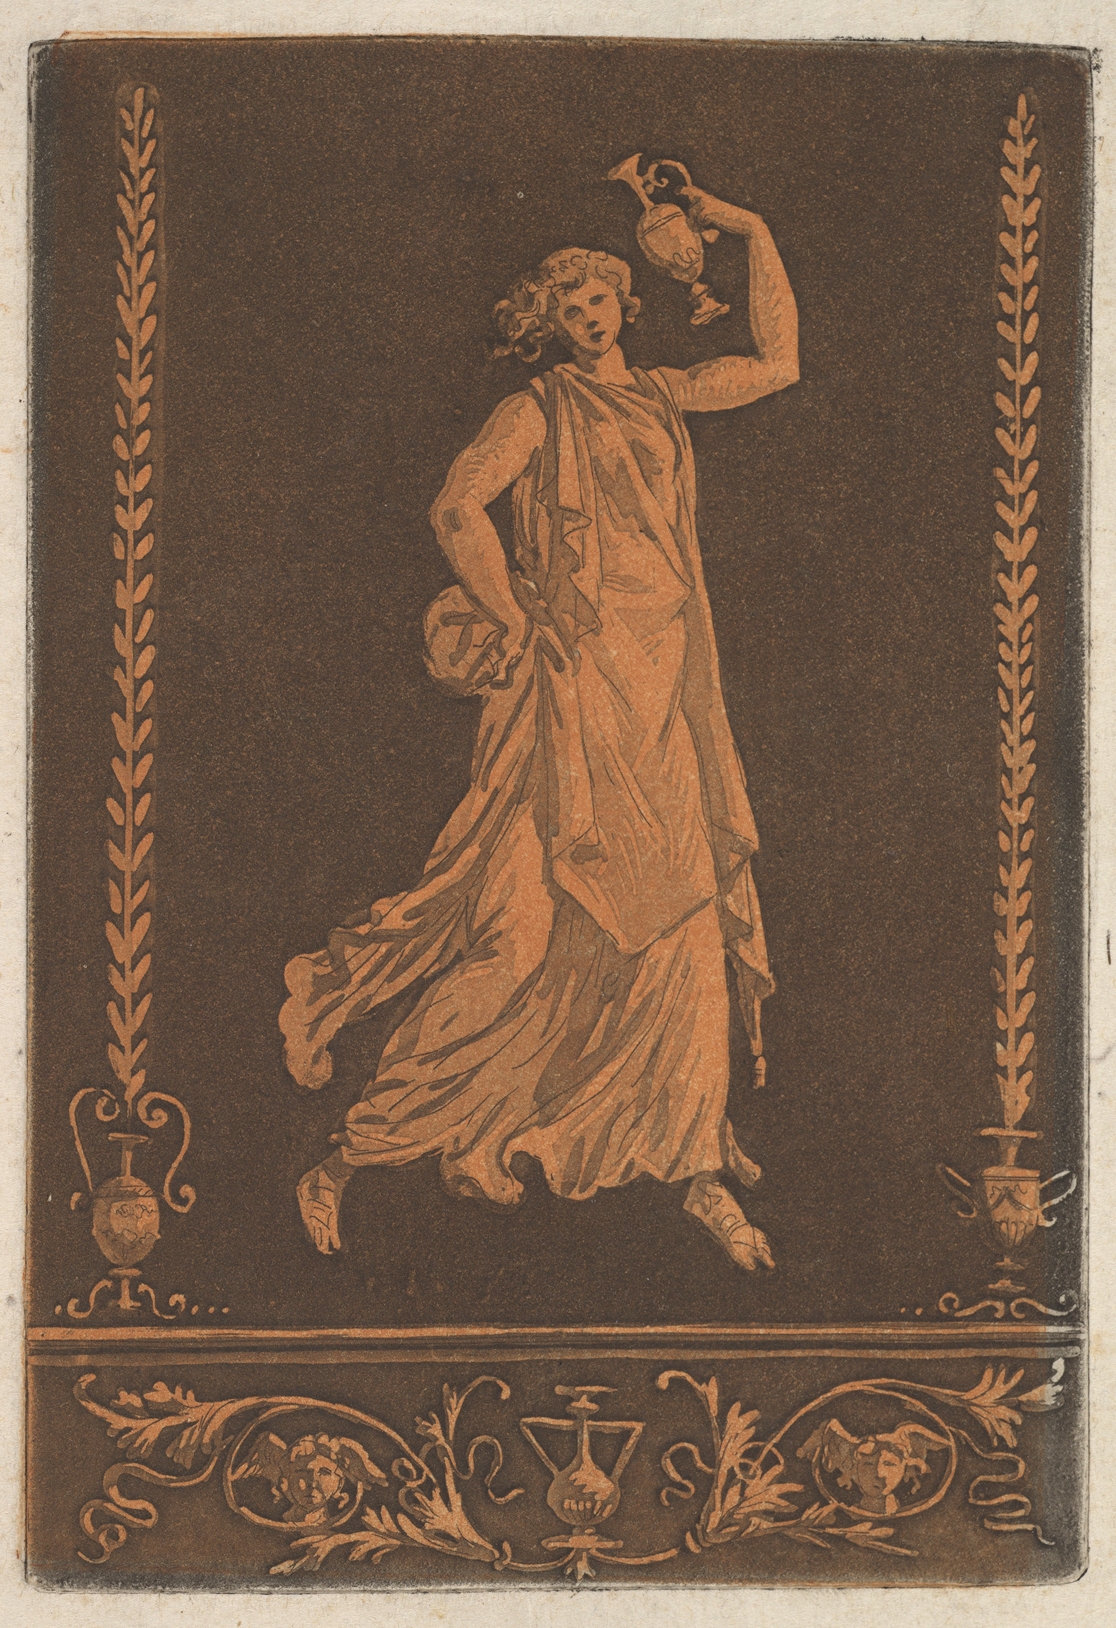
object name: print collection ornament architecture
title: Jeune femme drapée, marchant de gauche à droit, portant un vase de métal (Young draped woman, walking from left to right, carrying a metal vase in the style of red-figure vase painting), most likely from Recueil de Différentes Compositions Frises et Ornements dessinées et gravées à la manière du lavis par La Grenée le Juene Se trouve chez l'Auteur, au Louvre et chez Basan, rue et Hôtel Serpente A Paris, in an album containing Recueil de Compositions par Lagrenée Le Jeune (Collection of Compositions by Lagrenée the Younger)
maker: jean jacques lagrenée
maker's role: artist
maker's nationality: french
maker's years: 1739-1821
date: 1784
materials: ink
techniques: aquatint, etching, printing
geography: france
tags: ornament,women